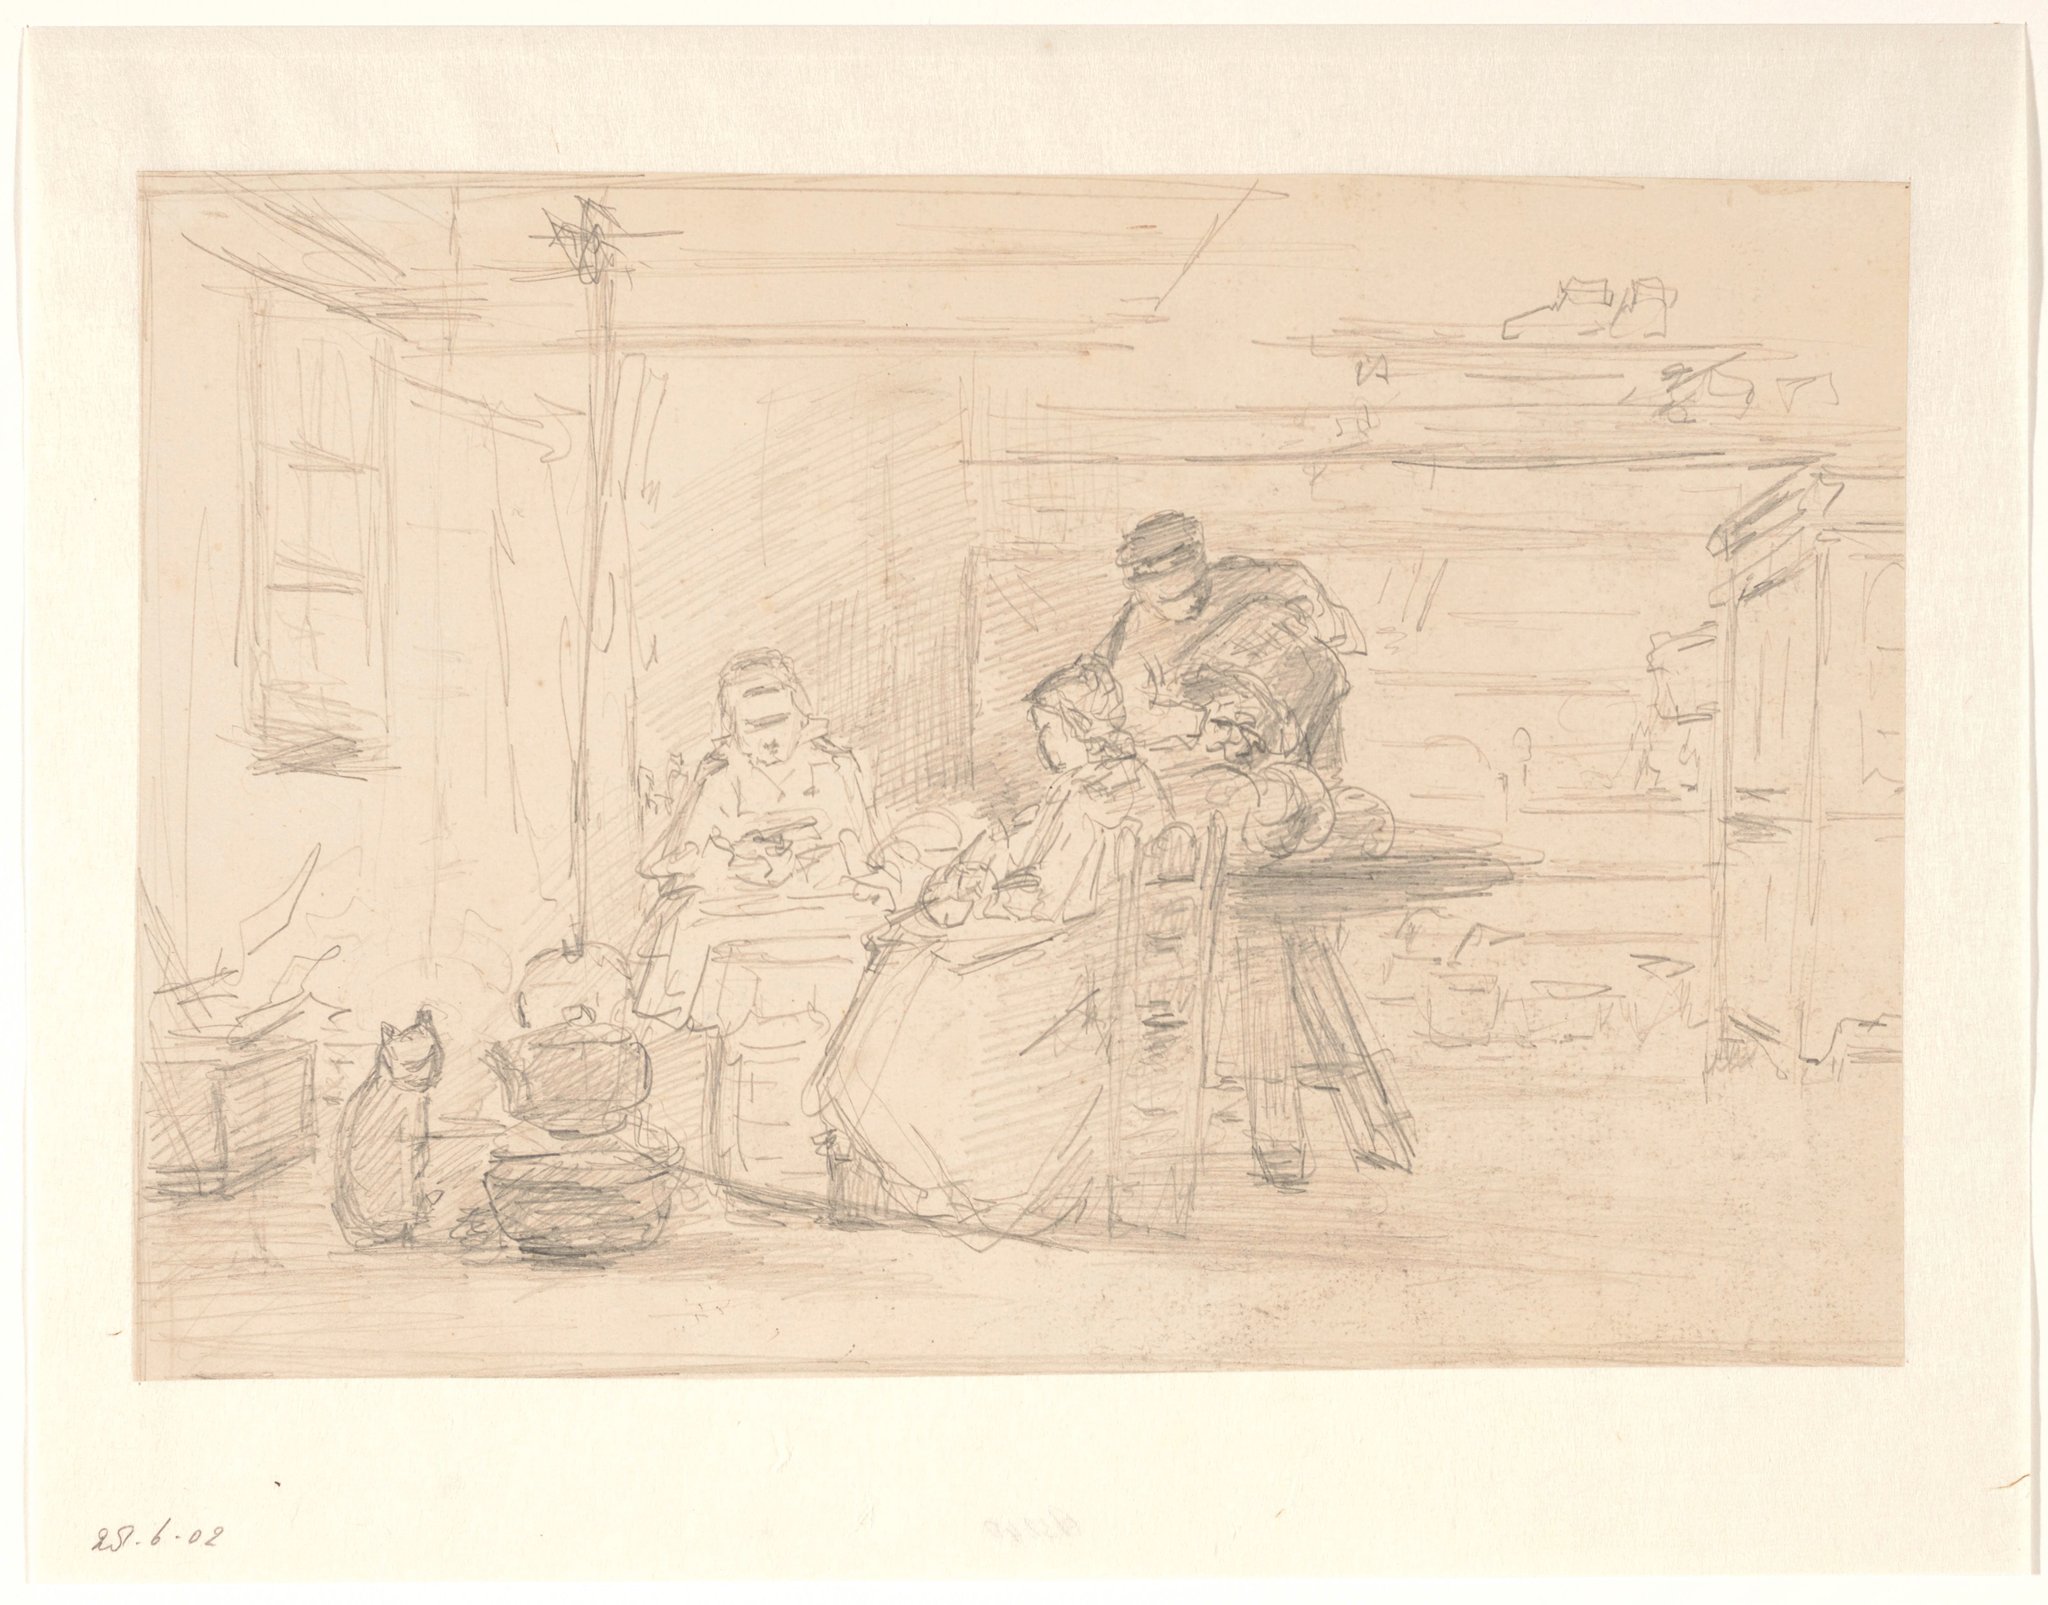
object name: drawing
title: Twee vrouwen aan een tafel en een man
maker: hendrik valkenburg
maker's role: draughtsman, painter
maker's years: 1826-1896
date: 1836-1896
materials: paper, pencil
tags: family group, especially parents with their child(ren), interior of the house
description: Interieur met twee vrouwen zittend aan een tafel en een man die een korf daarop leeggiet.